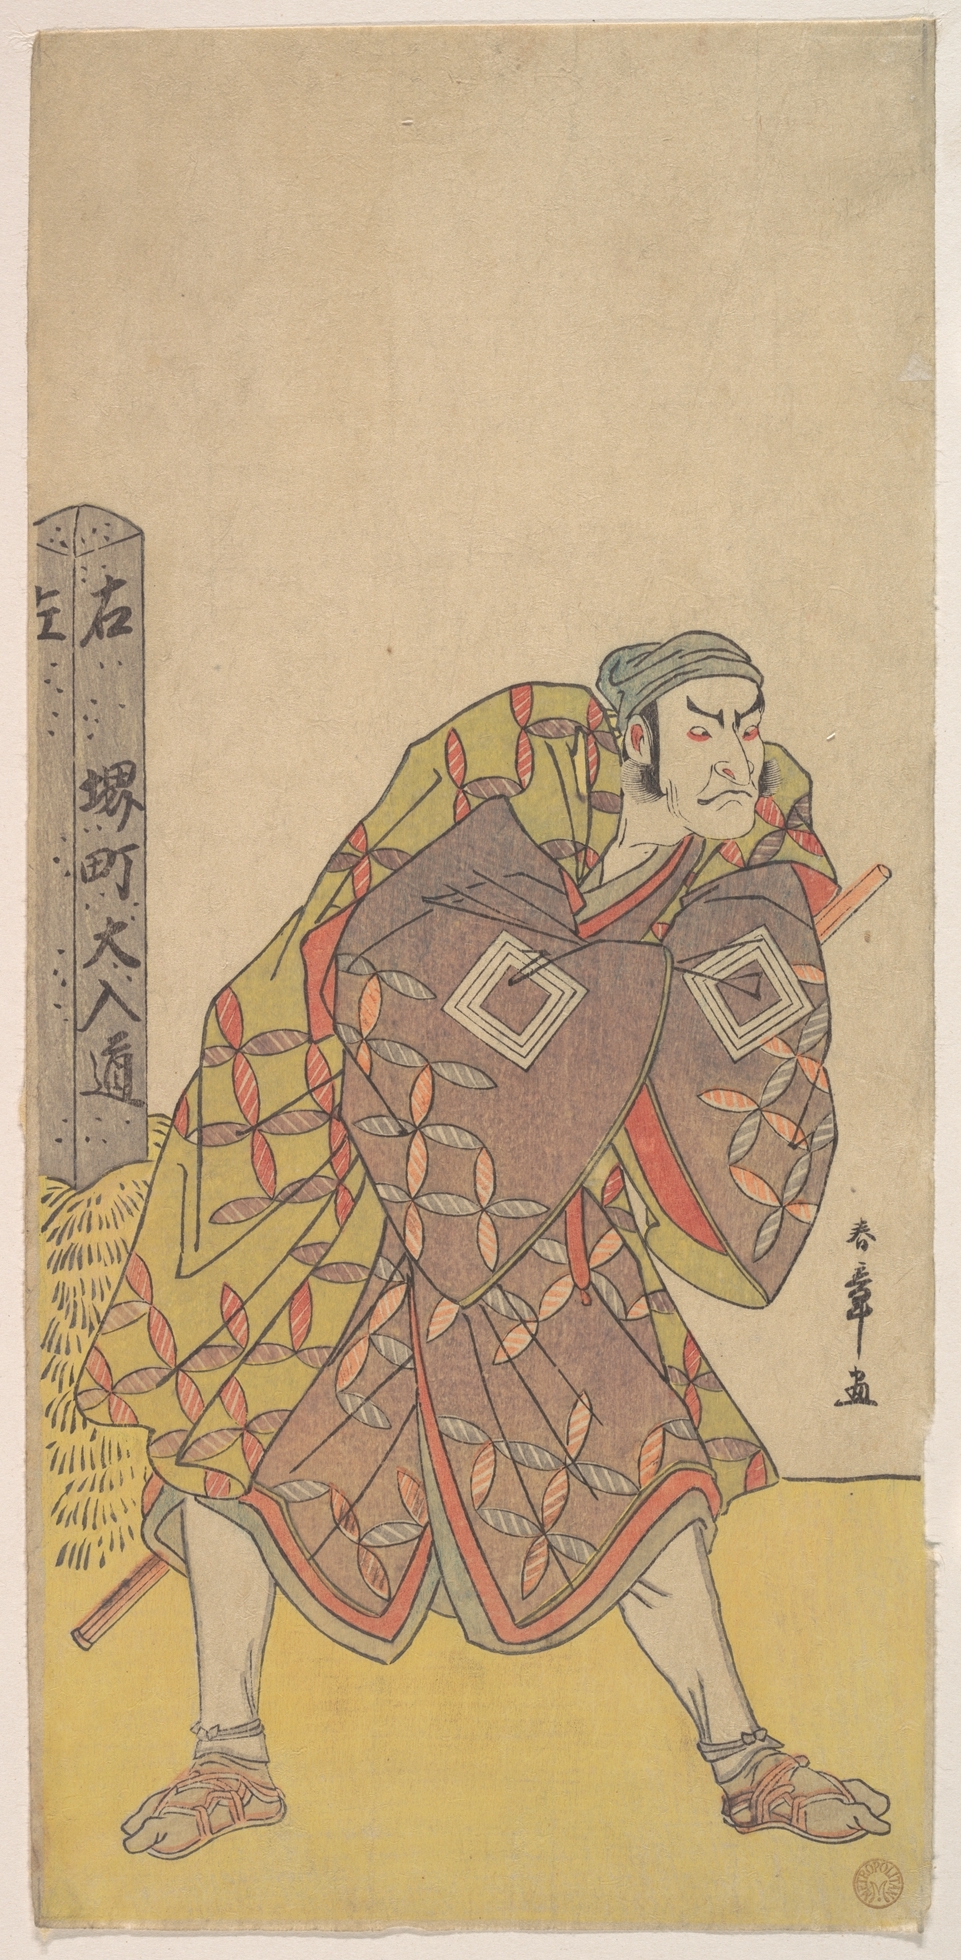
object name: woodblock print nishiki e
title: The Fifth Ichikawa Danjuro as a Kago Bearer Standing Near a Mile Post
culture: japanese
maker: katsukawa shunshō 勝川春章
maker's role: artist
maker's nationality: japanese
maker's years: 1726-1792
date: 1783-1784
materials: ink, paper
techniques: nishiki e, woodblock print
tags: men,actors